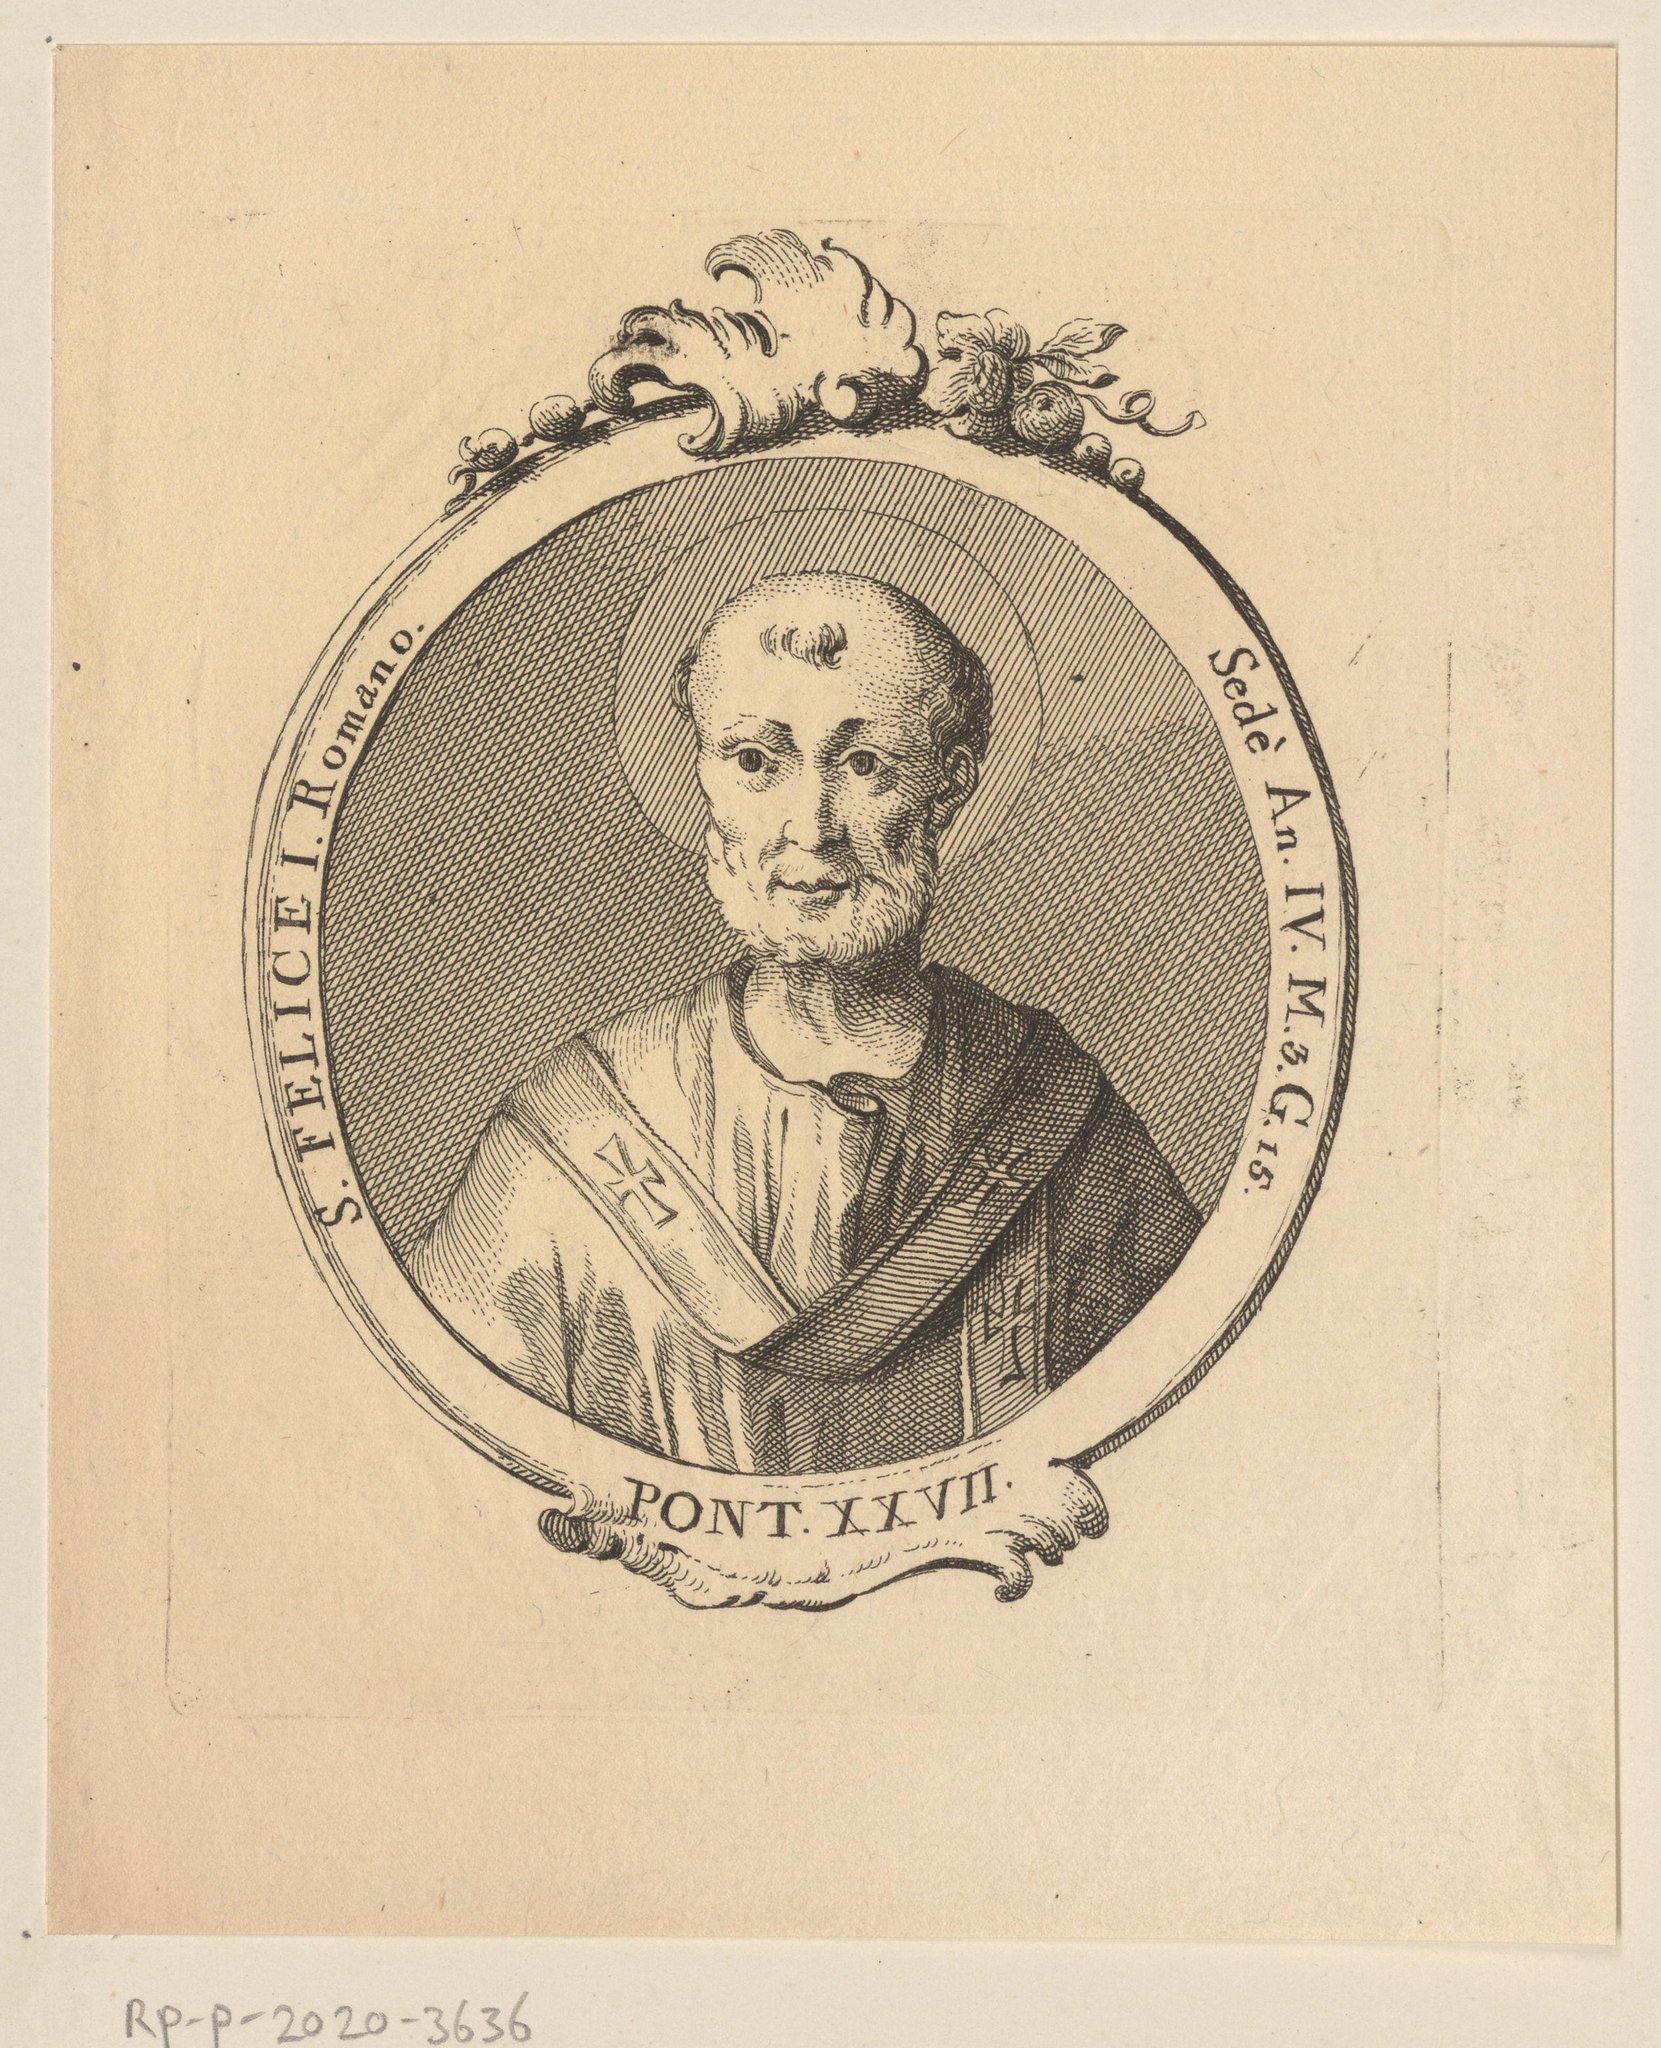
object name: print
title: Portret van paus Felix I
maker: Anonymous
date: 1775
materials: paper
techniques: etching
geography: italy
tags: historical persons, pope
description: Prent waarschijnlijk uit: Effigies Romanorum pontificum a S. Petro ad Pium VI (...). 2 dln. Venetië en Bassano del Grappa: Giuseppe Remondini, 1775. Prent met tekst in boekdruk op verso gebruikt in een deel van: Platina (Bartholomaeus Sacchi). Storia delle vite dei pontefici da Platina e d'altri autori (...). 5 dln. Venetië: Domenico Ferrarin, 1760-1769.